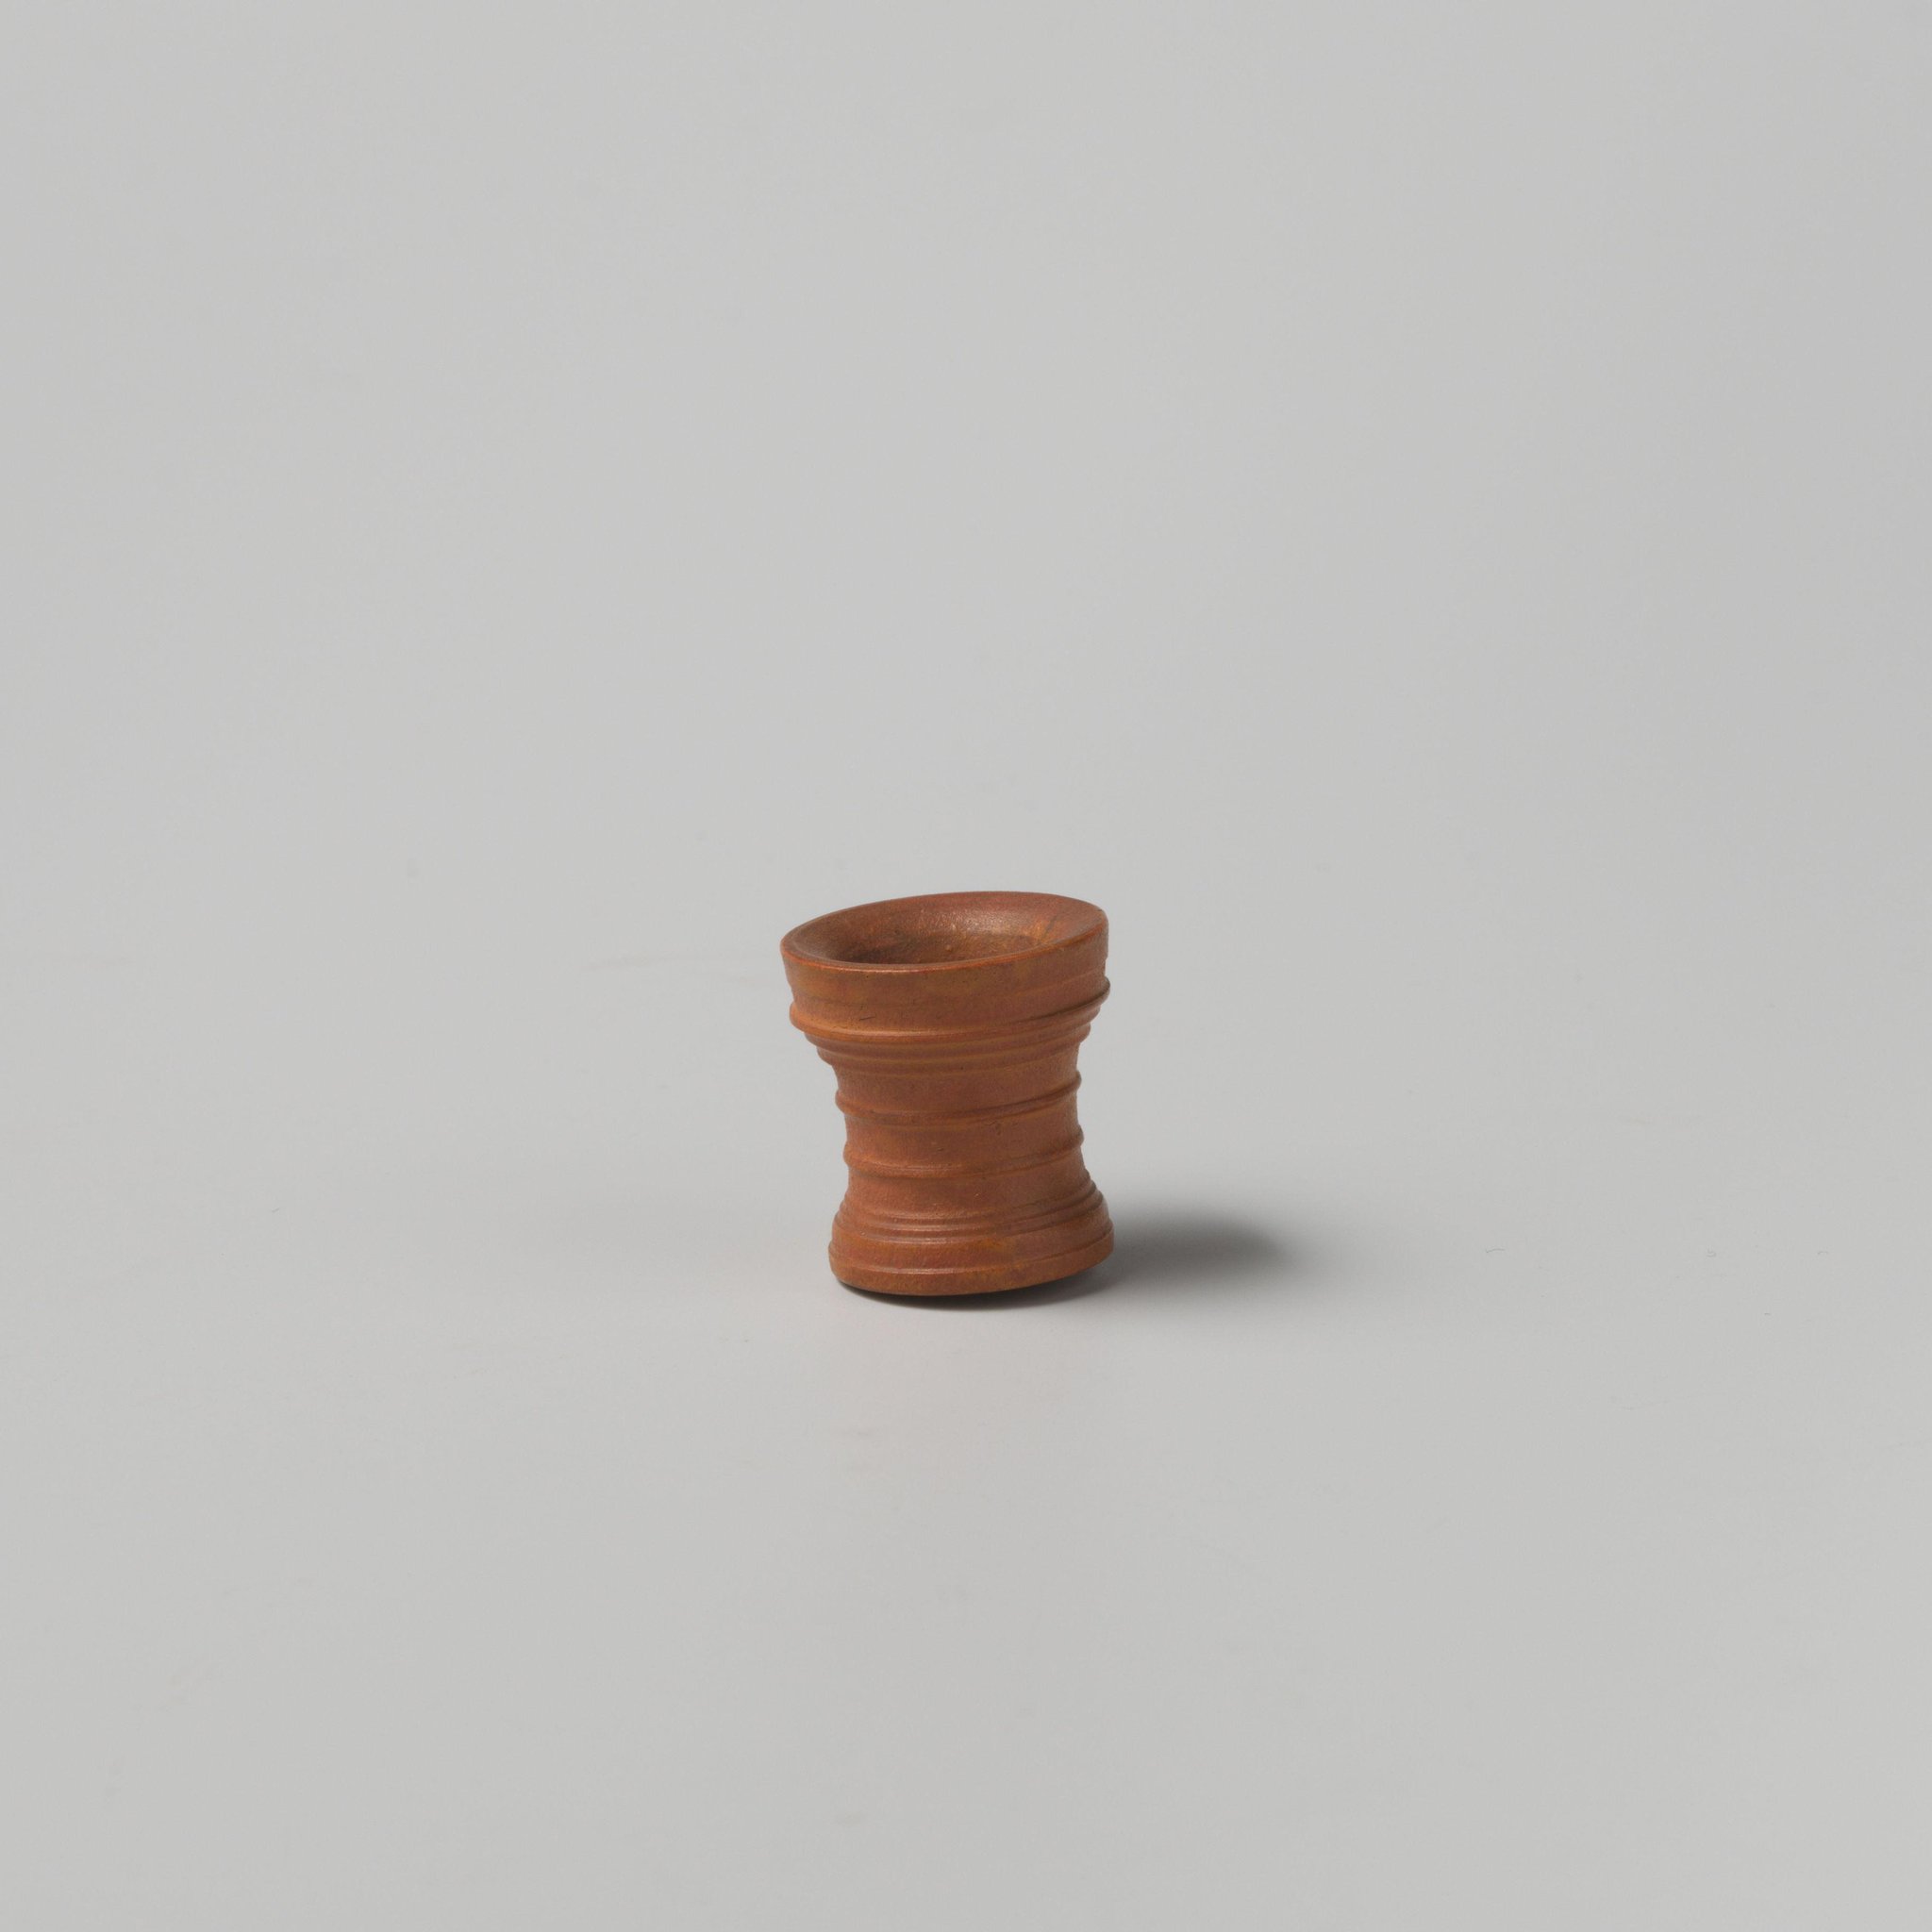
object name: mortar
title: Vijzel, gedraaid van esdoornhout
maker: Anonymous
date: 1675-1699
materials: wood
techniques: turning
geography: amsterdam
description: Vijzel, gedraaid van esdoornhout, oranjegeverfd.